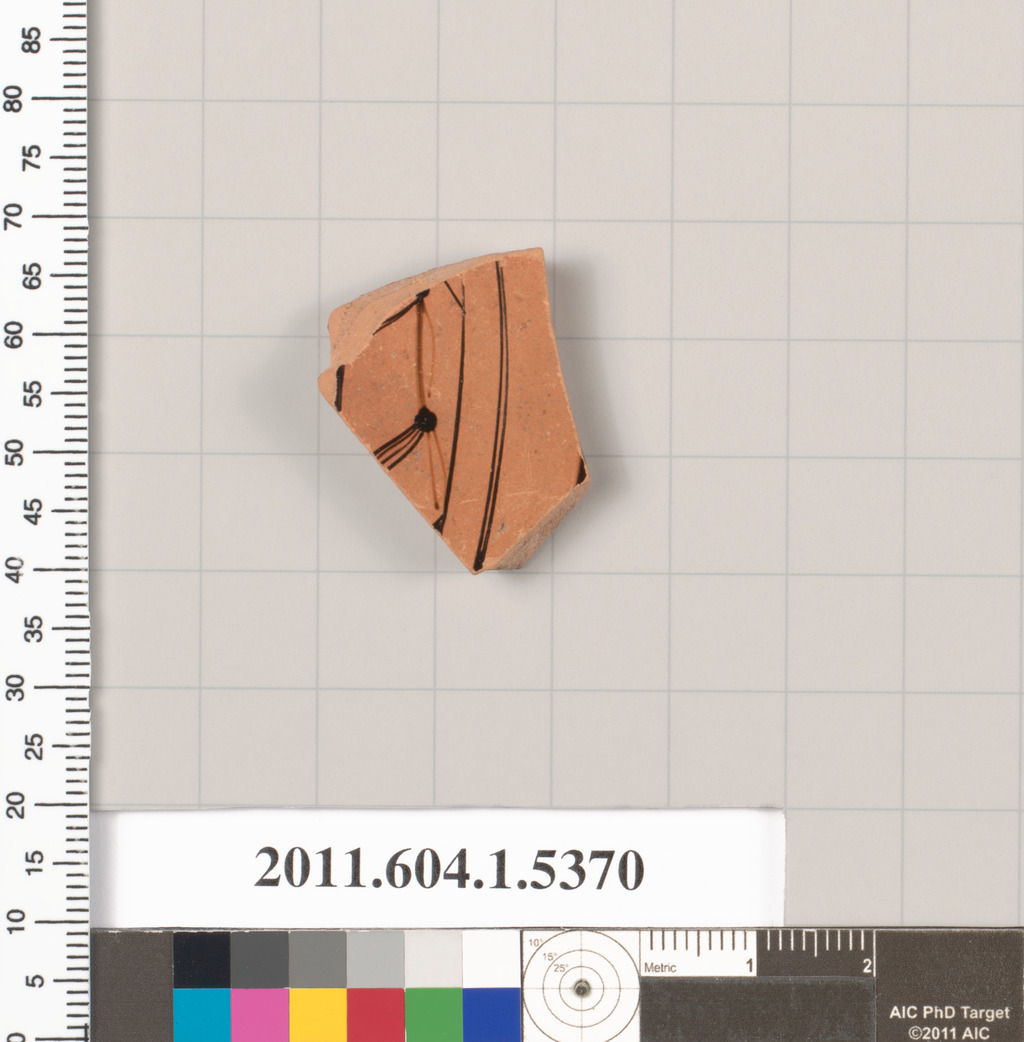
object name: kylix fragment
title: Terracotta fragment of a kylix (drinking cup)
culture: greek, attic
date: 500-490 BCE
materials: terracotta